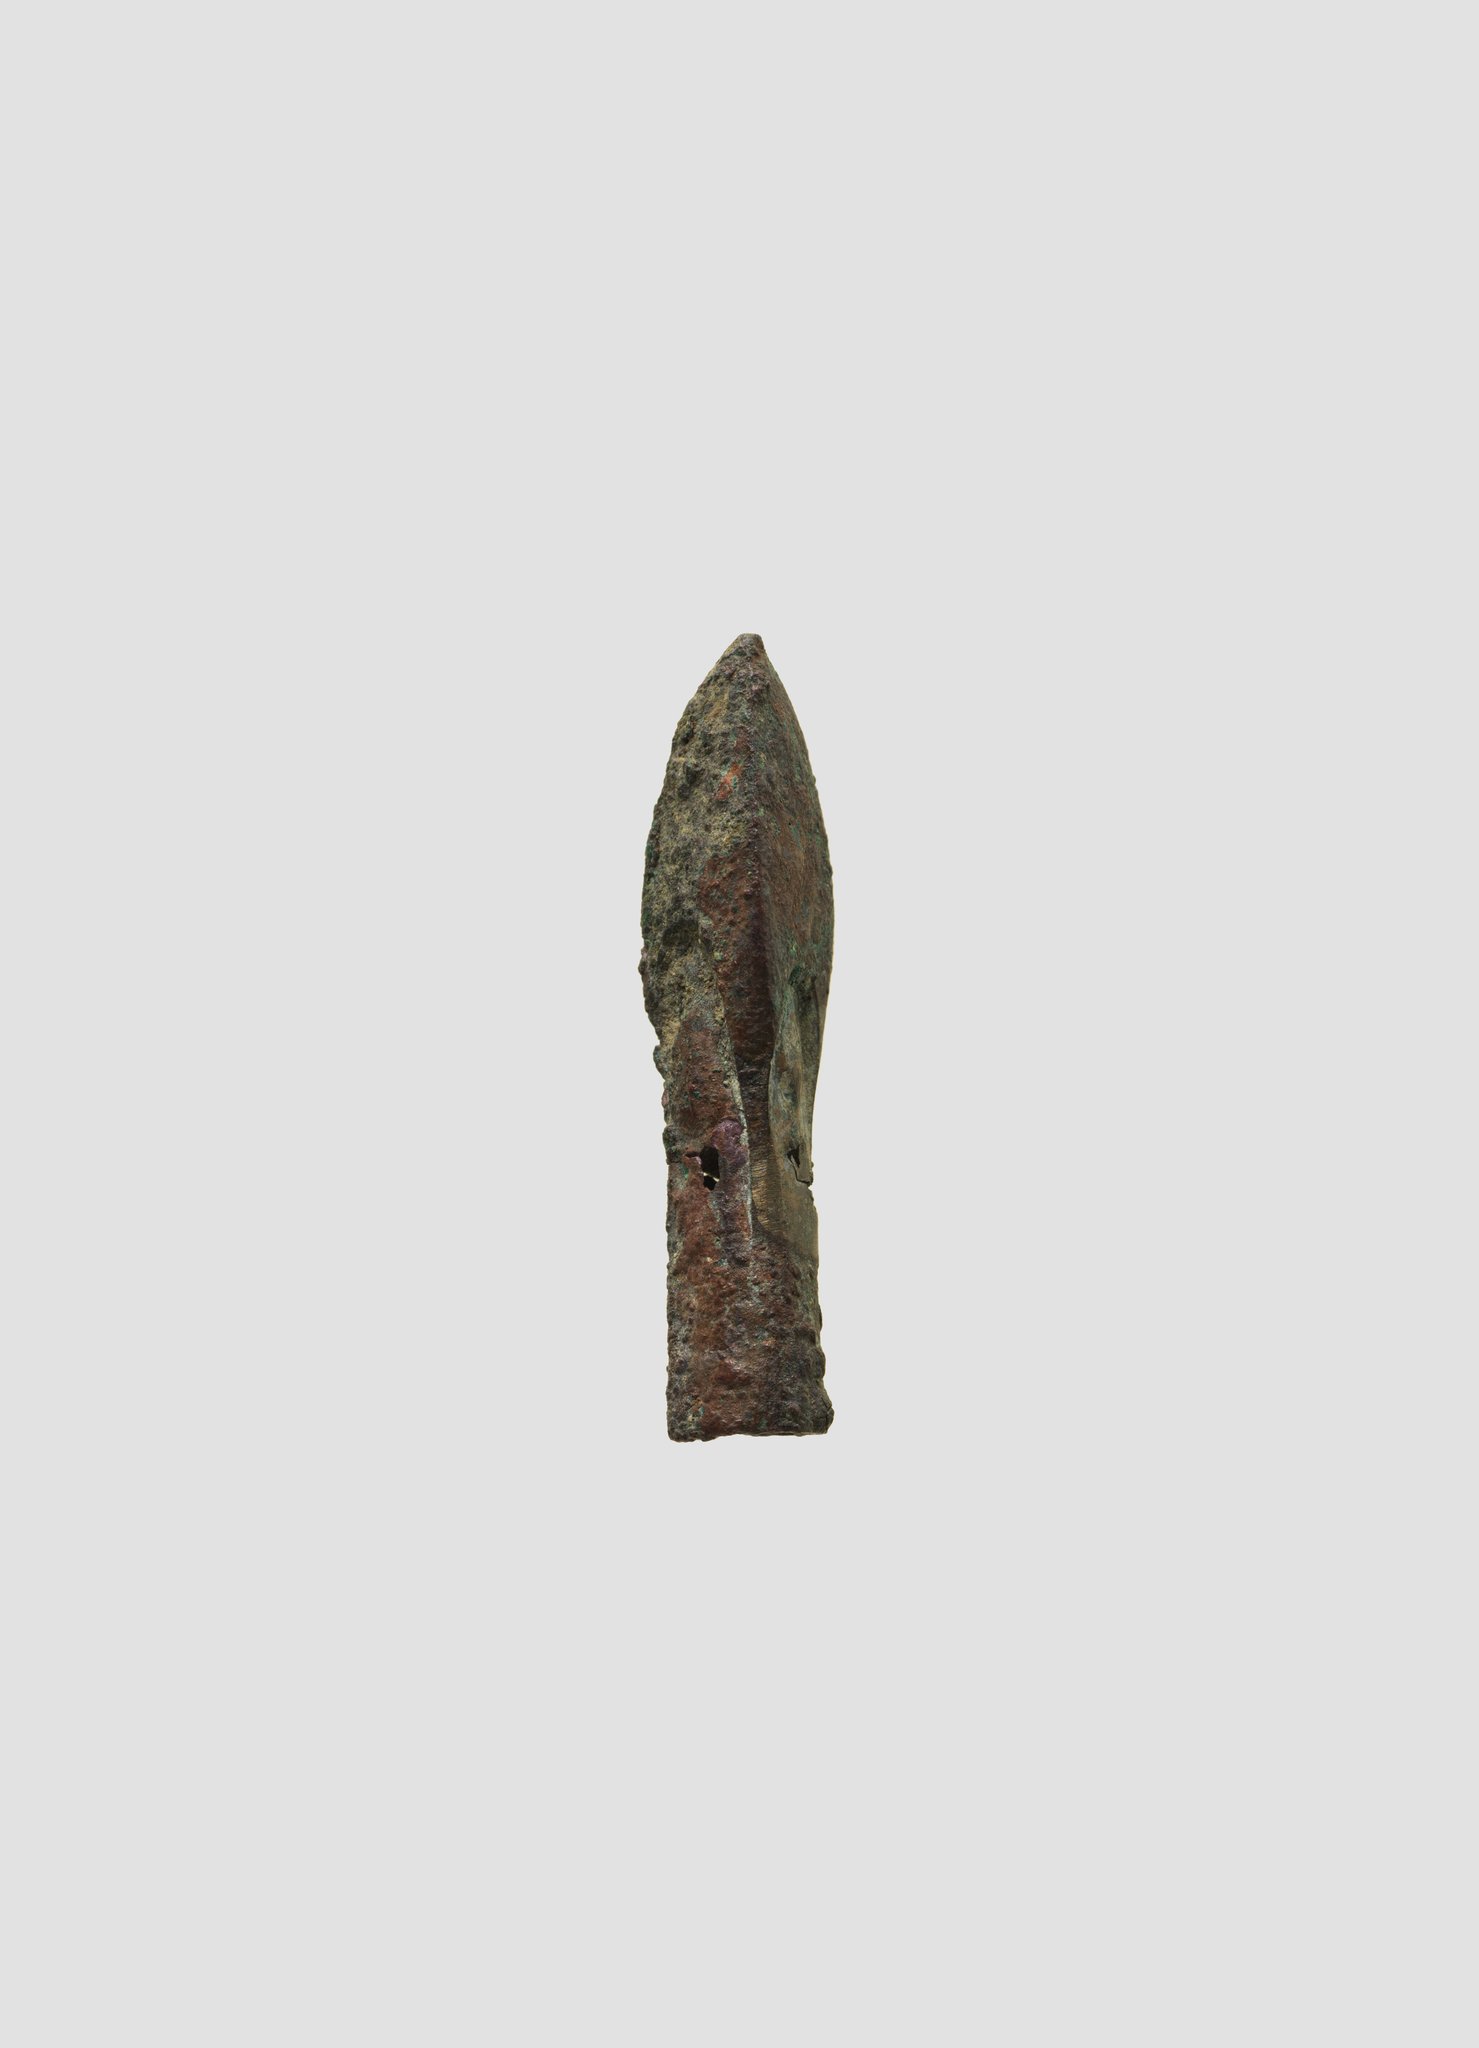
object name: arrowhead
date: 601-700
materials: bronze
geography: iran